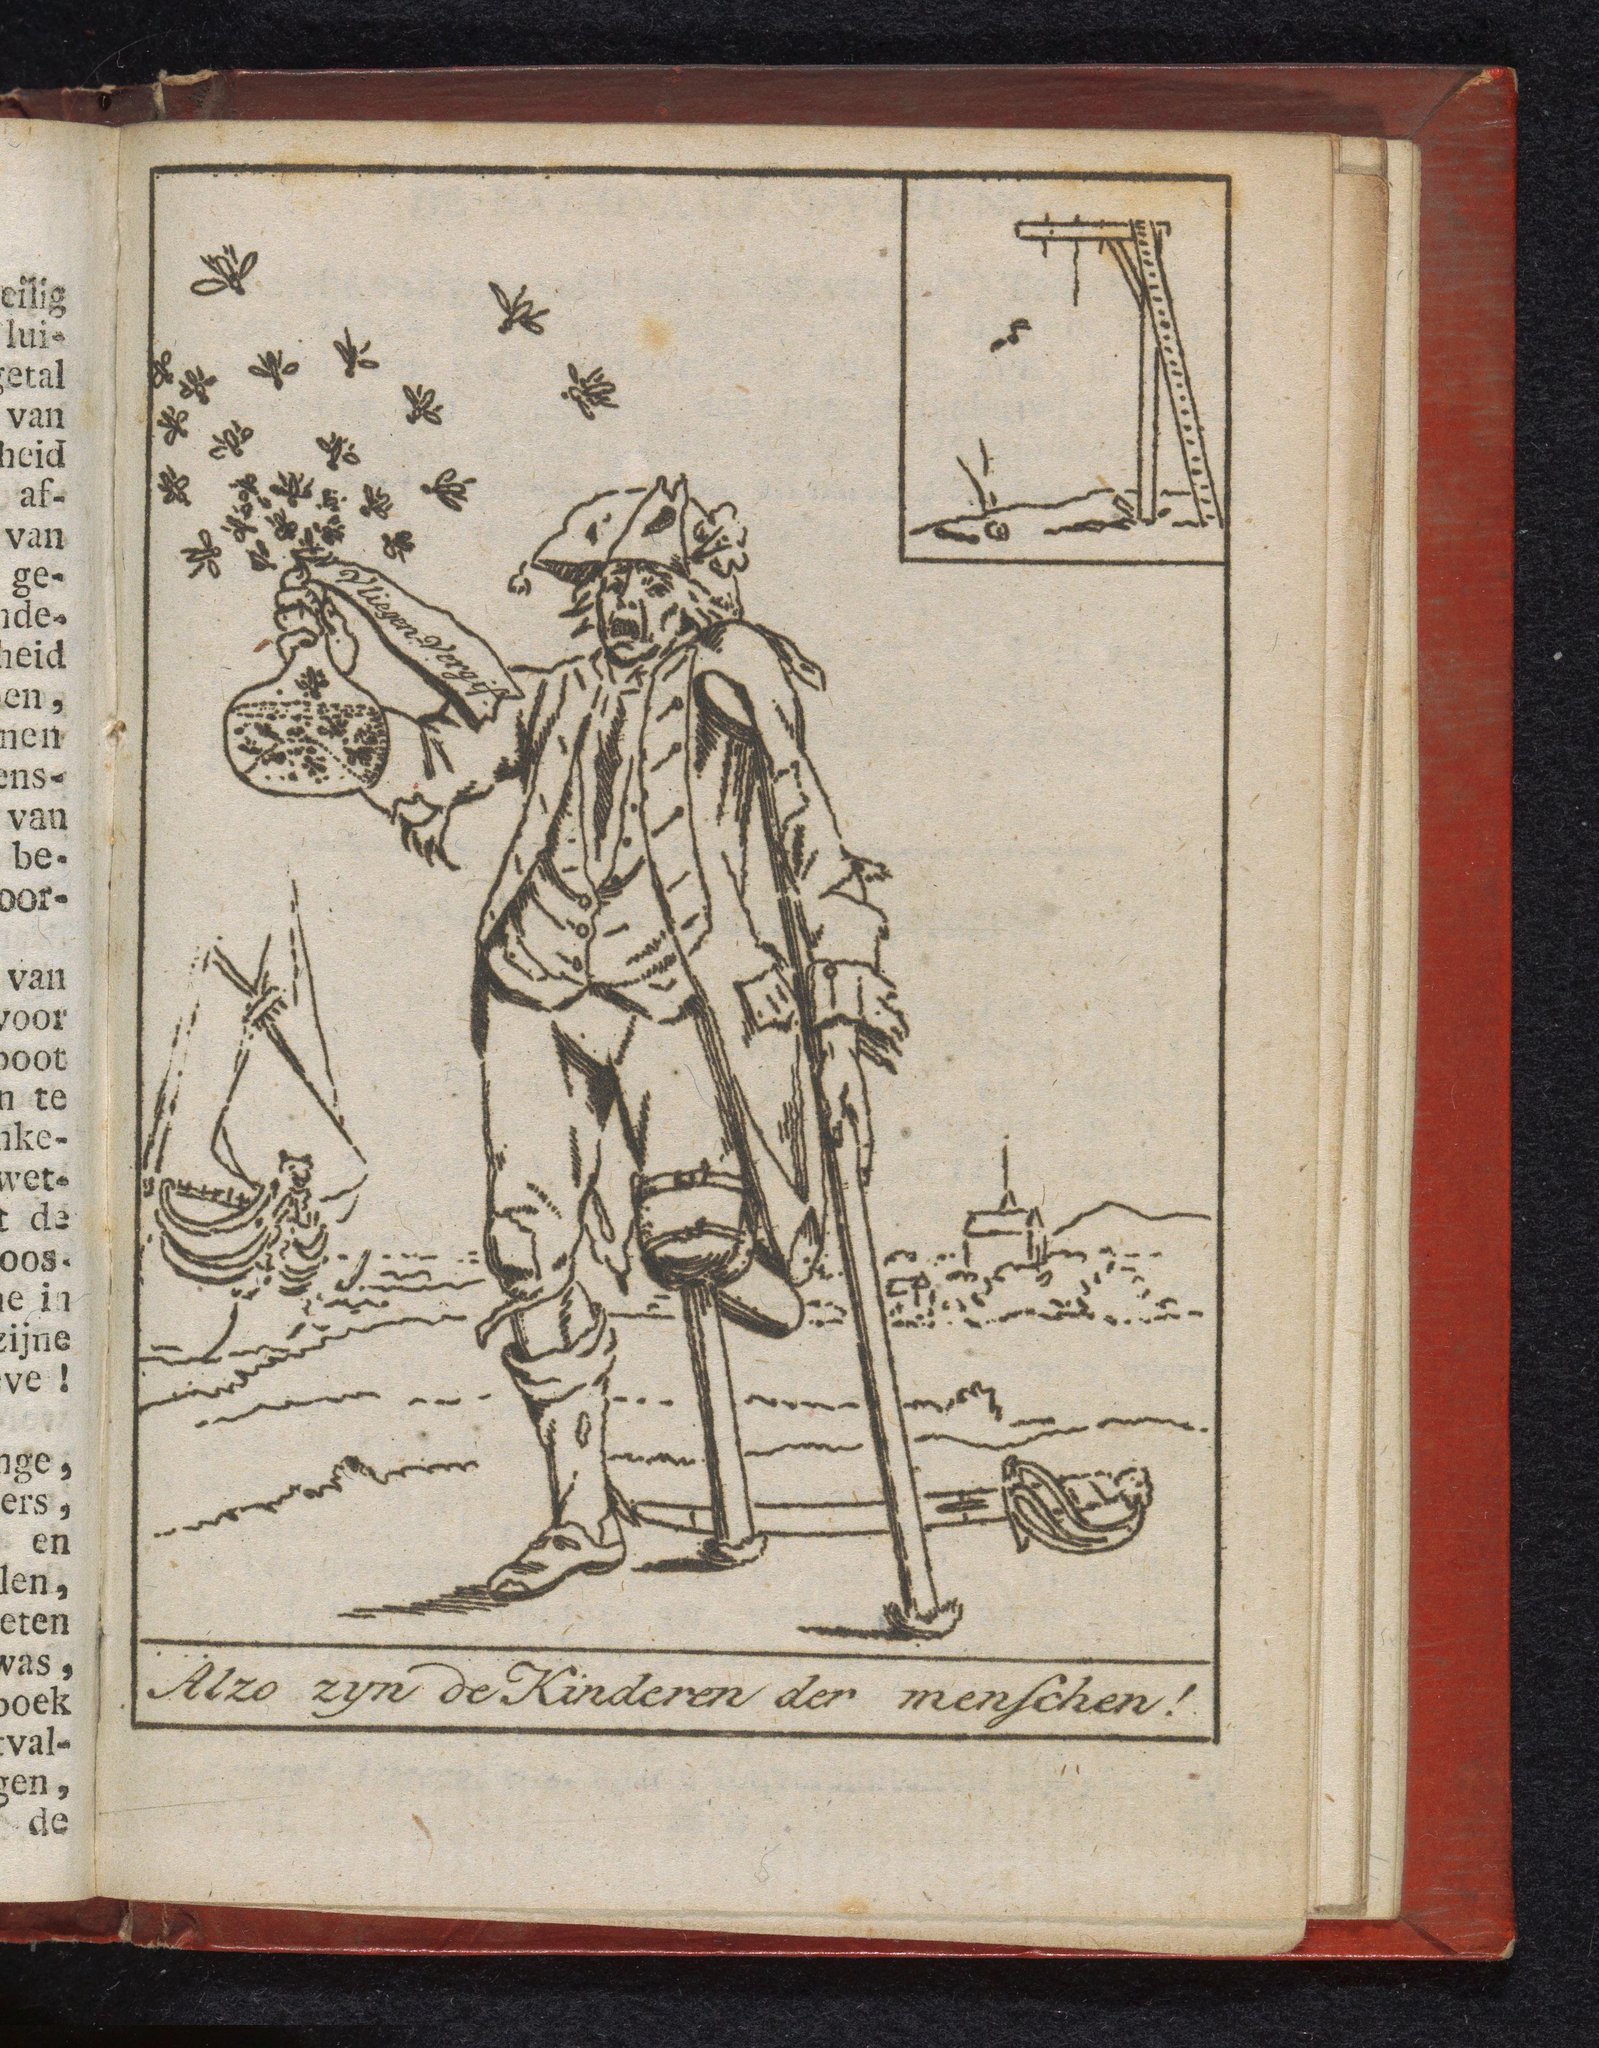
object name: cartoon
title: Kreupele met vliegengif, 1796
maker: pieter van woensel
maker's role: print maker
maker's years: 1747-1808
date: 1795-1796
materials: paper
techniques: etching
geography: netherlands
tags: wooden leg, person with a physical disability, pedlar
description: Spotprent van een man met een houten been en krukken, mogelijk een oorlogsinvalide veteraan, die een fles met vliegengif omhoog houdt waar een zwerm vliegen op af komt. Illustratie in Pieter van Woensels almanak 'De Lantaarn voor 1796'.